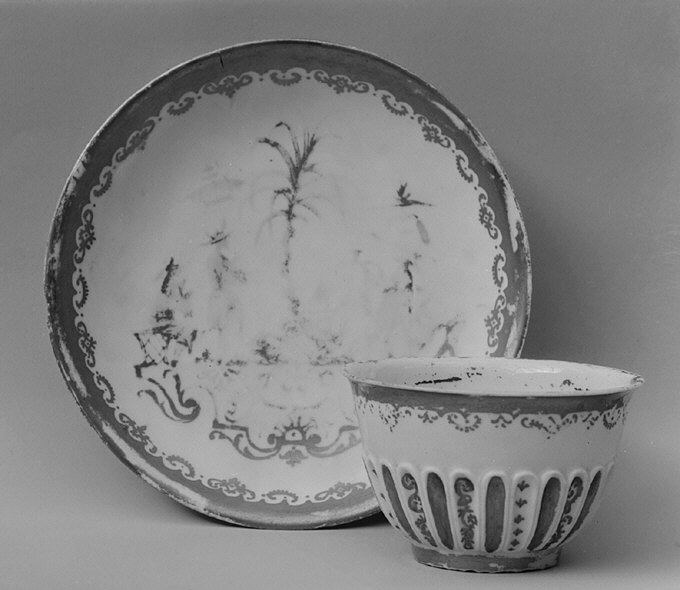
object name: saucer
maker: meissen manufactory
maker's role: manufactory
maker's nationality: german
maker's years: 1710-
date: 1720-1725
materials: hard paste porcelain